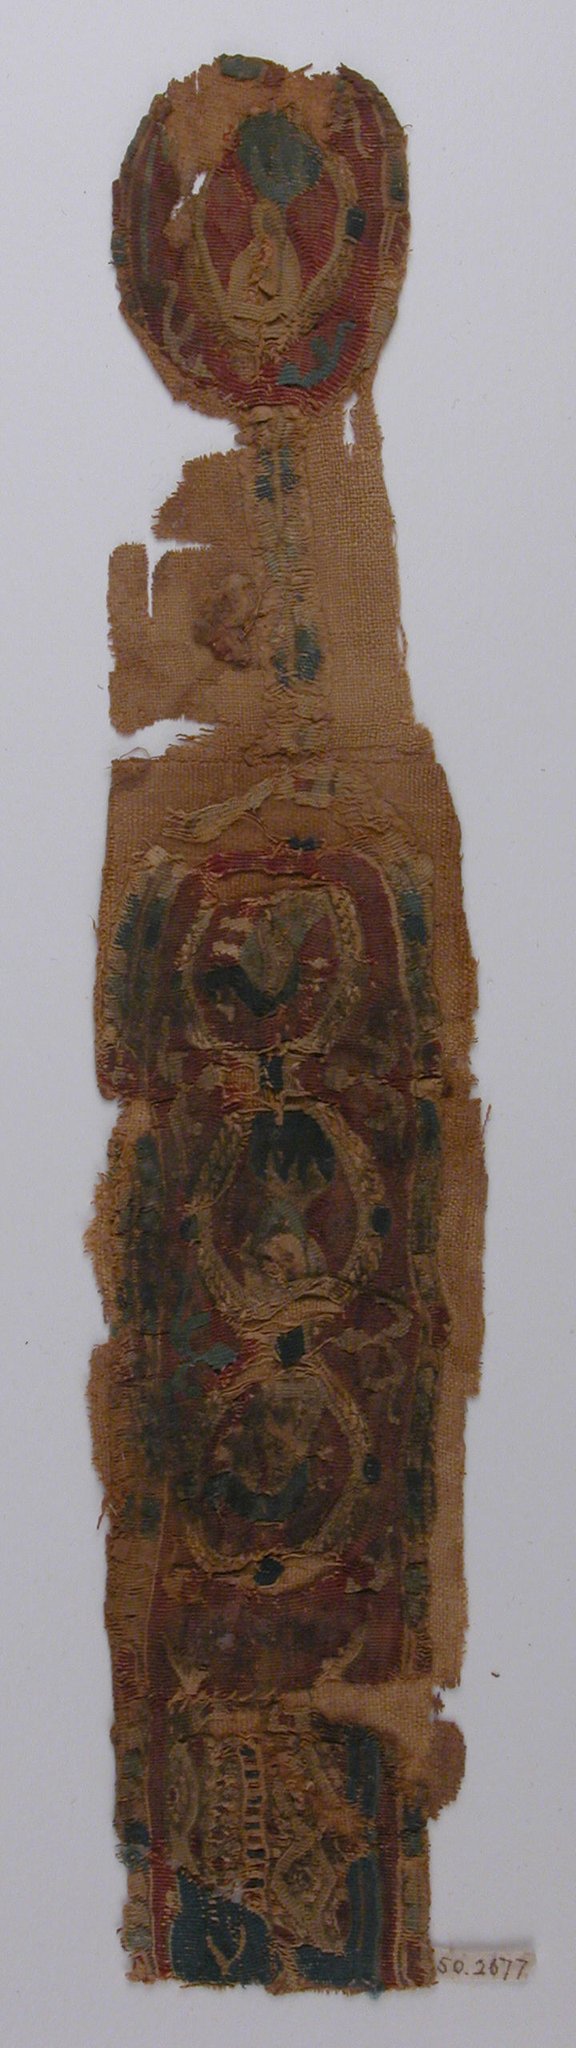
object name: shoulder band fragment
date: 501-800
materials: wool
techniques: weave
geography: egypt